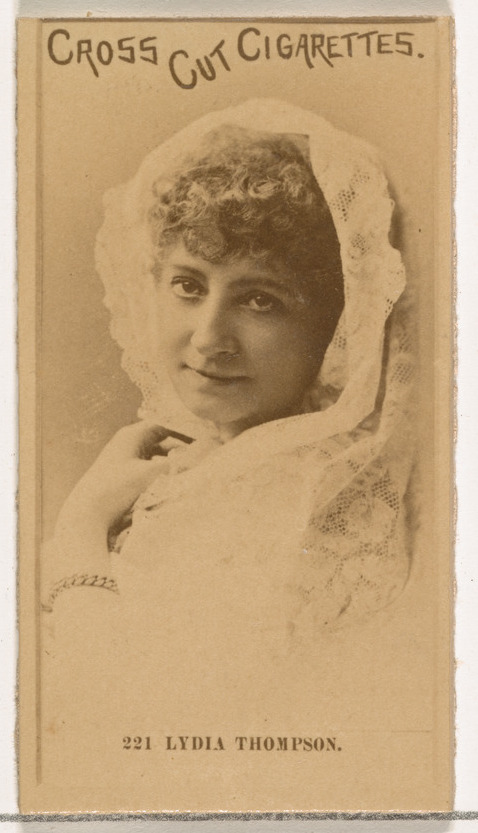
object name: print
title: Card Number 221, Lydia Thompson, from the Actors and Actresses series (N145-2) issued by Duke Sons & Co. to promote Cross Cut Cigarettes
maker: w. duke, sons & co.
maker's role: publisher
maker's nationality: american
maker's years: 1870-1920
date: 1880-1889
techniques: albumen silver print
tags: portraits,women,actresses